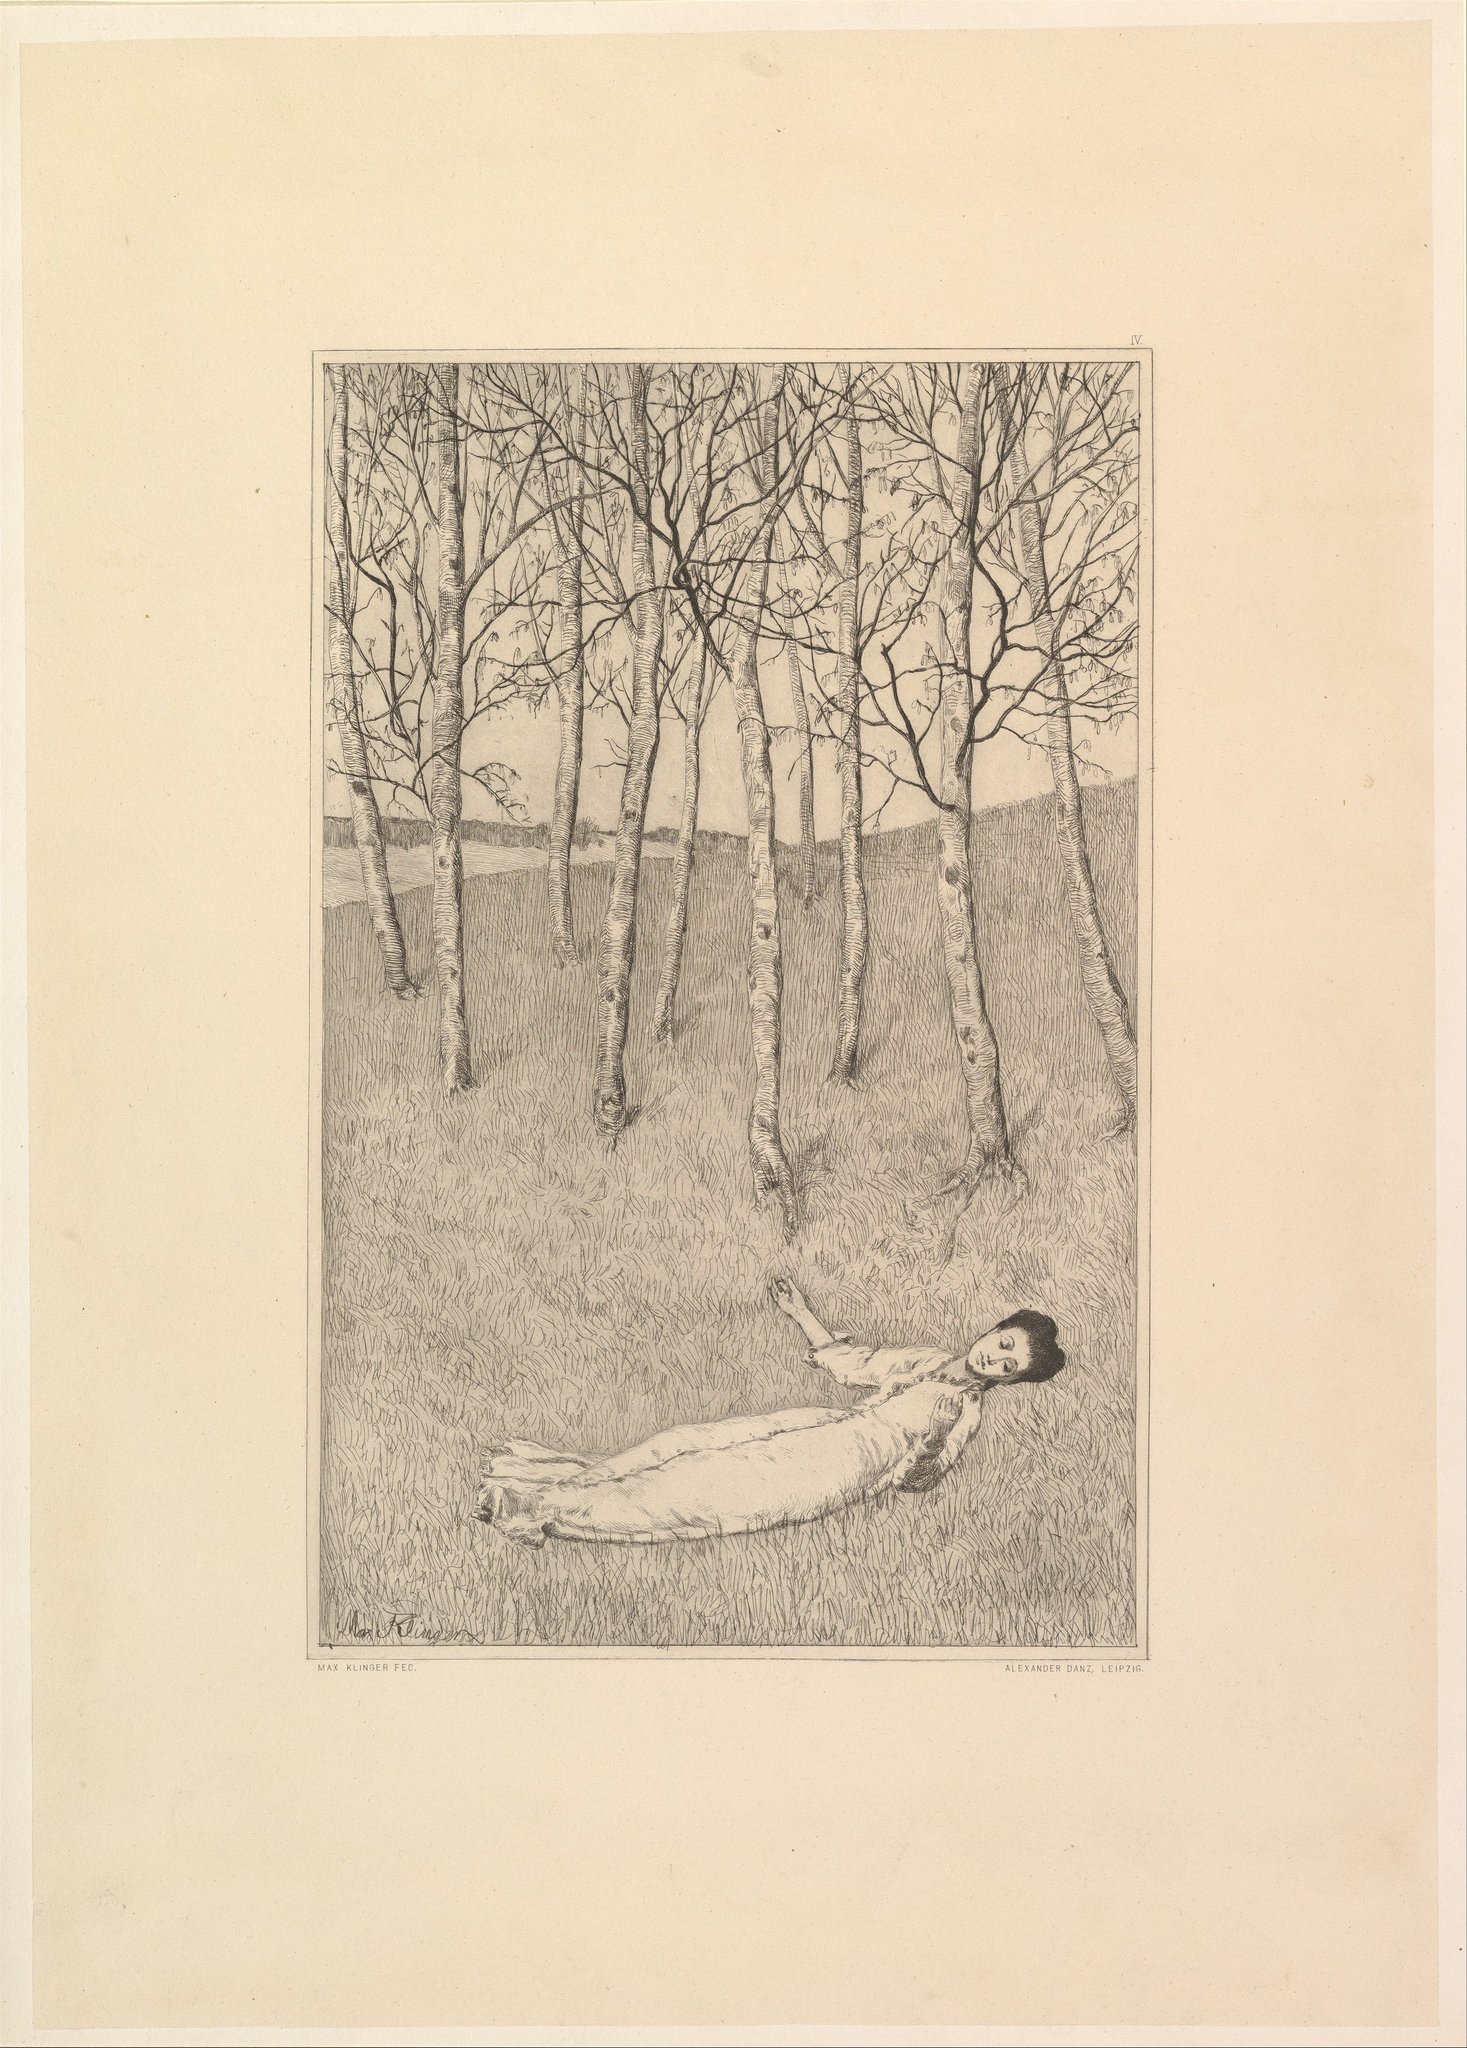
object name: print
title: Frühlingsanfang, from the series "Radierte Skizzen"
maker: max klinger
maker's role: artist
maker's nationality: german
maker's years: 1857-1920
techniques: aquatint, printmaking, etching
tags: women,trees